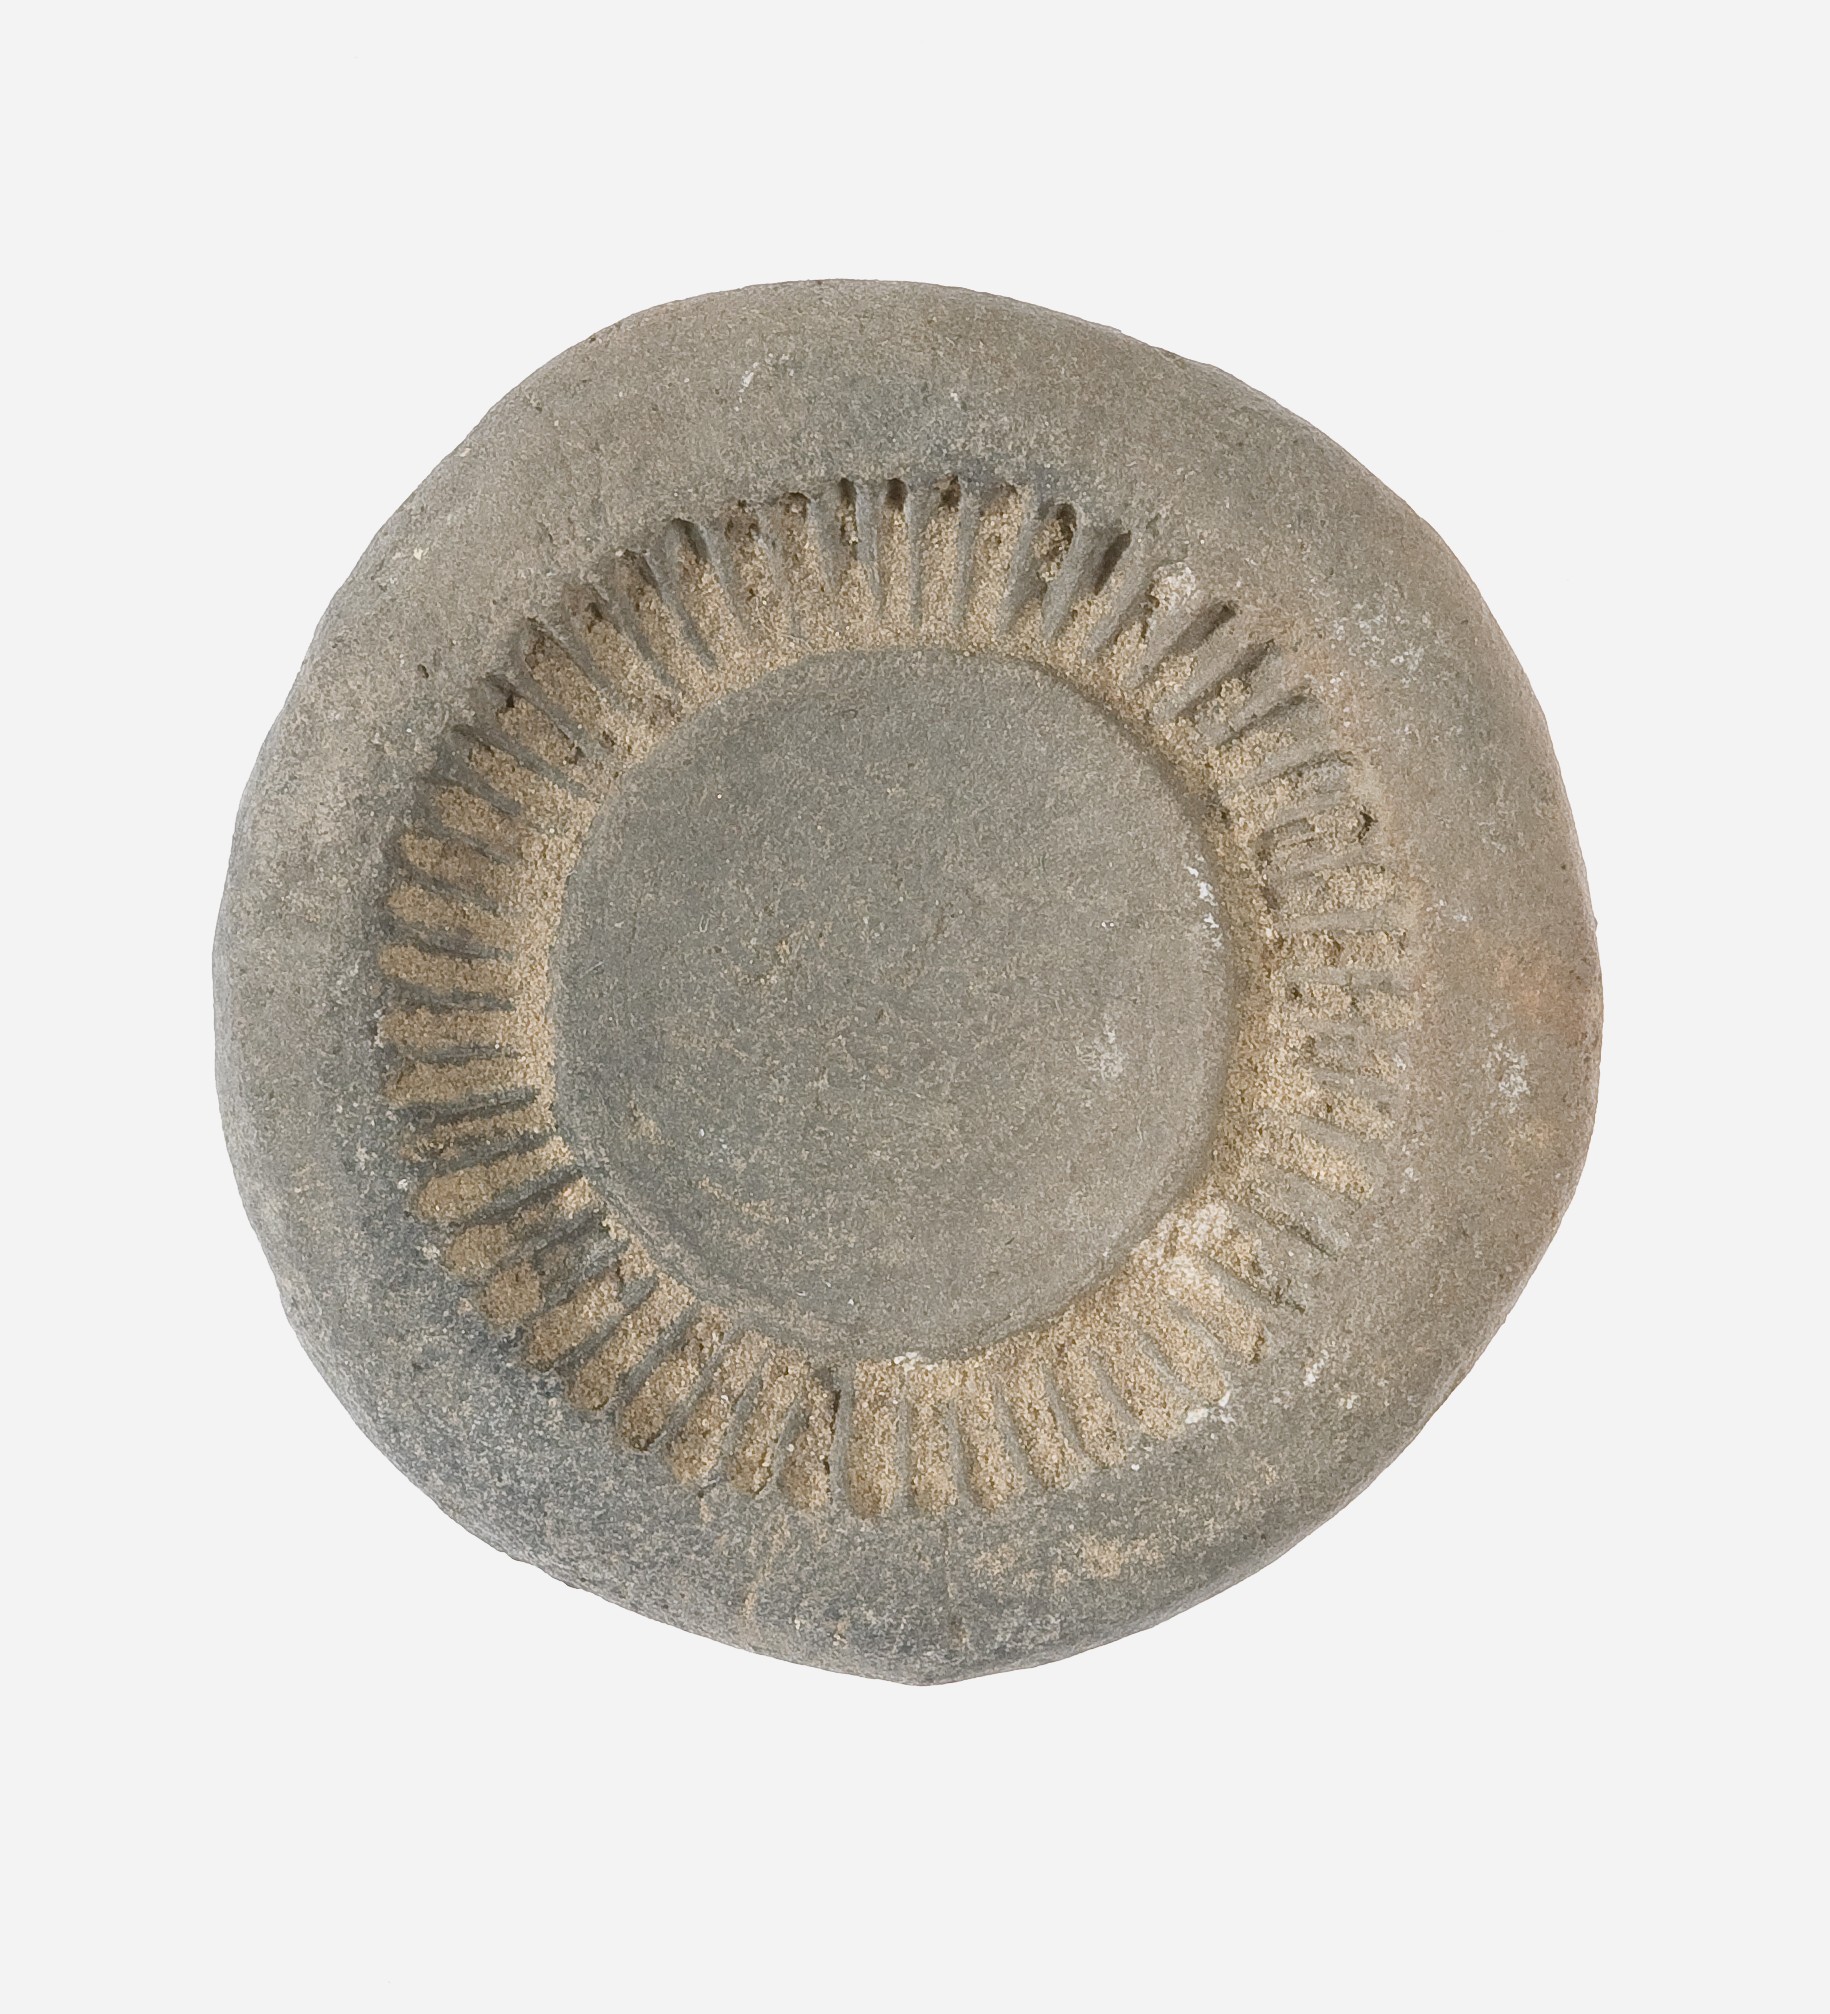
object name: mold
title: Mold for big ring ornaments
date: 1390-1352 BCE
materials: pottery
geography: egypt